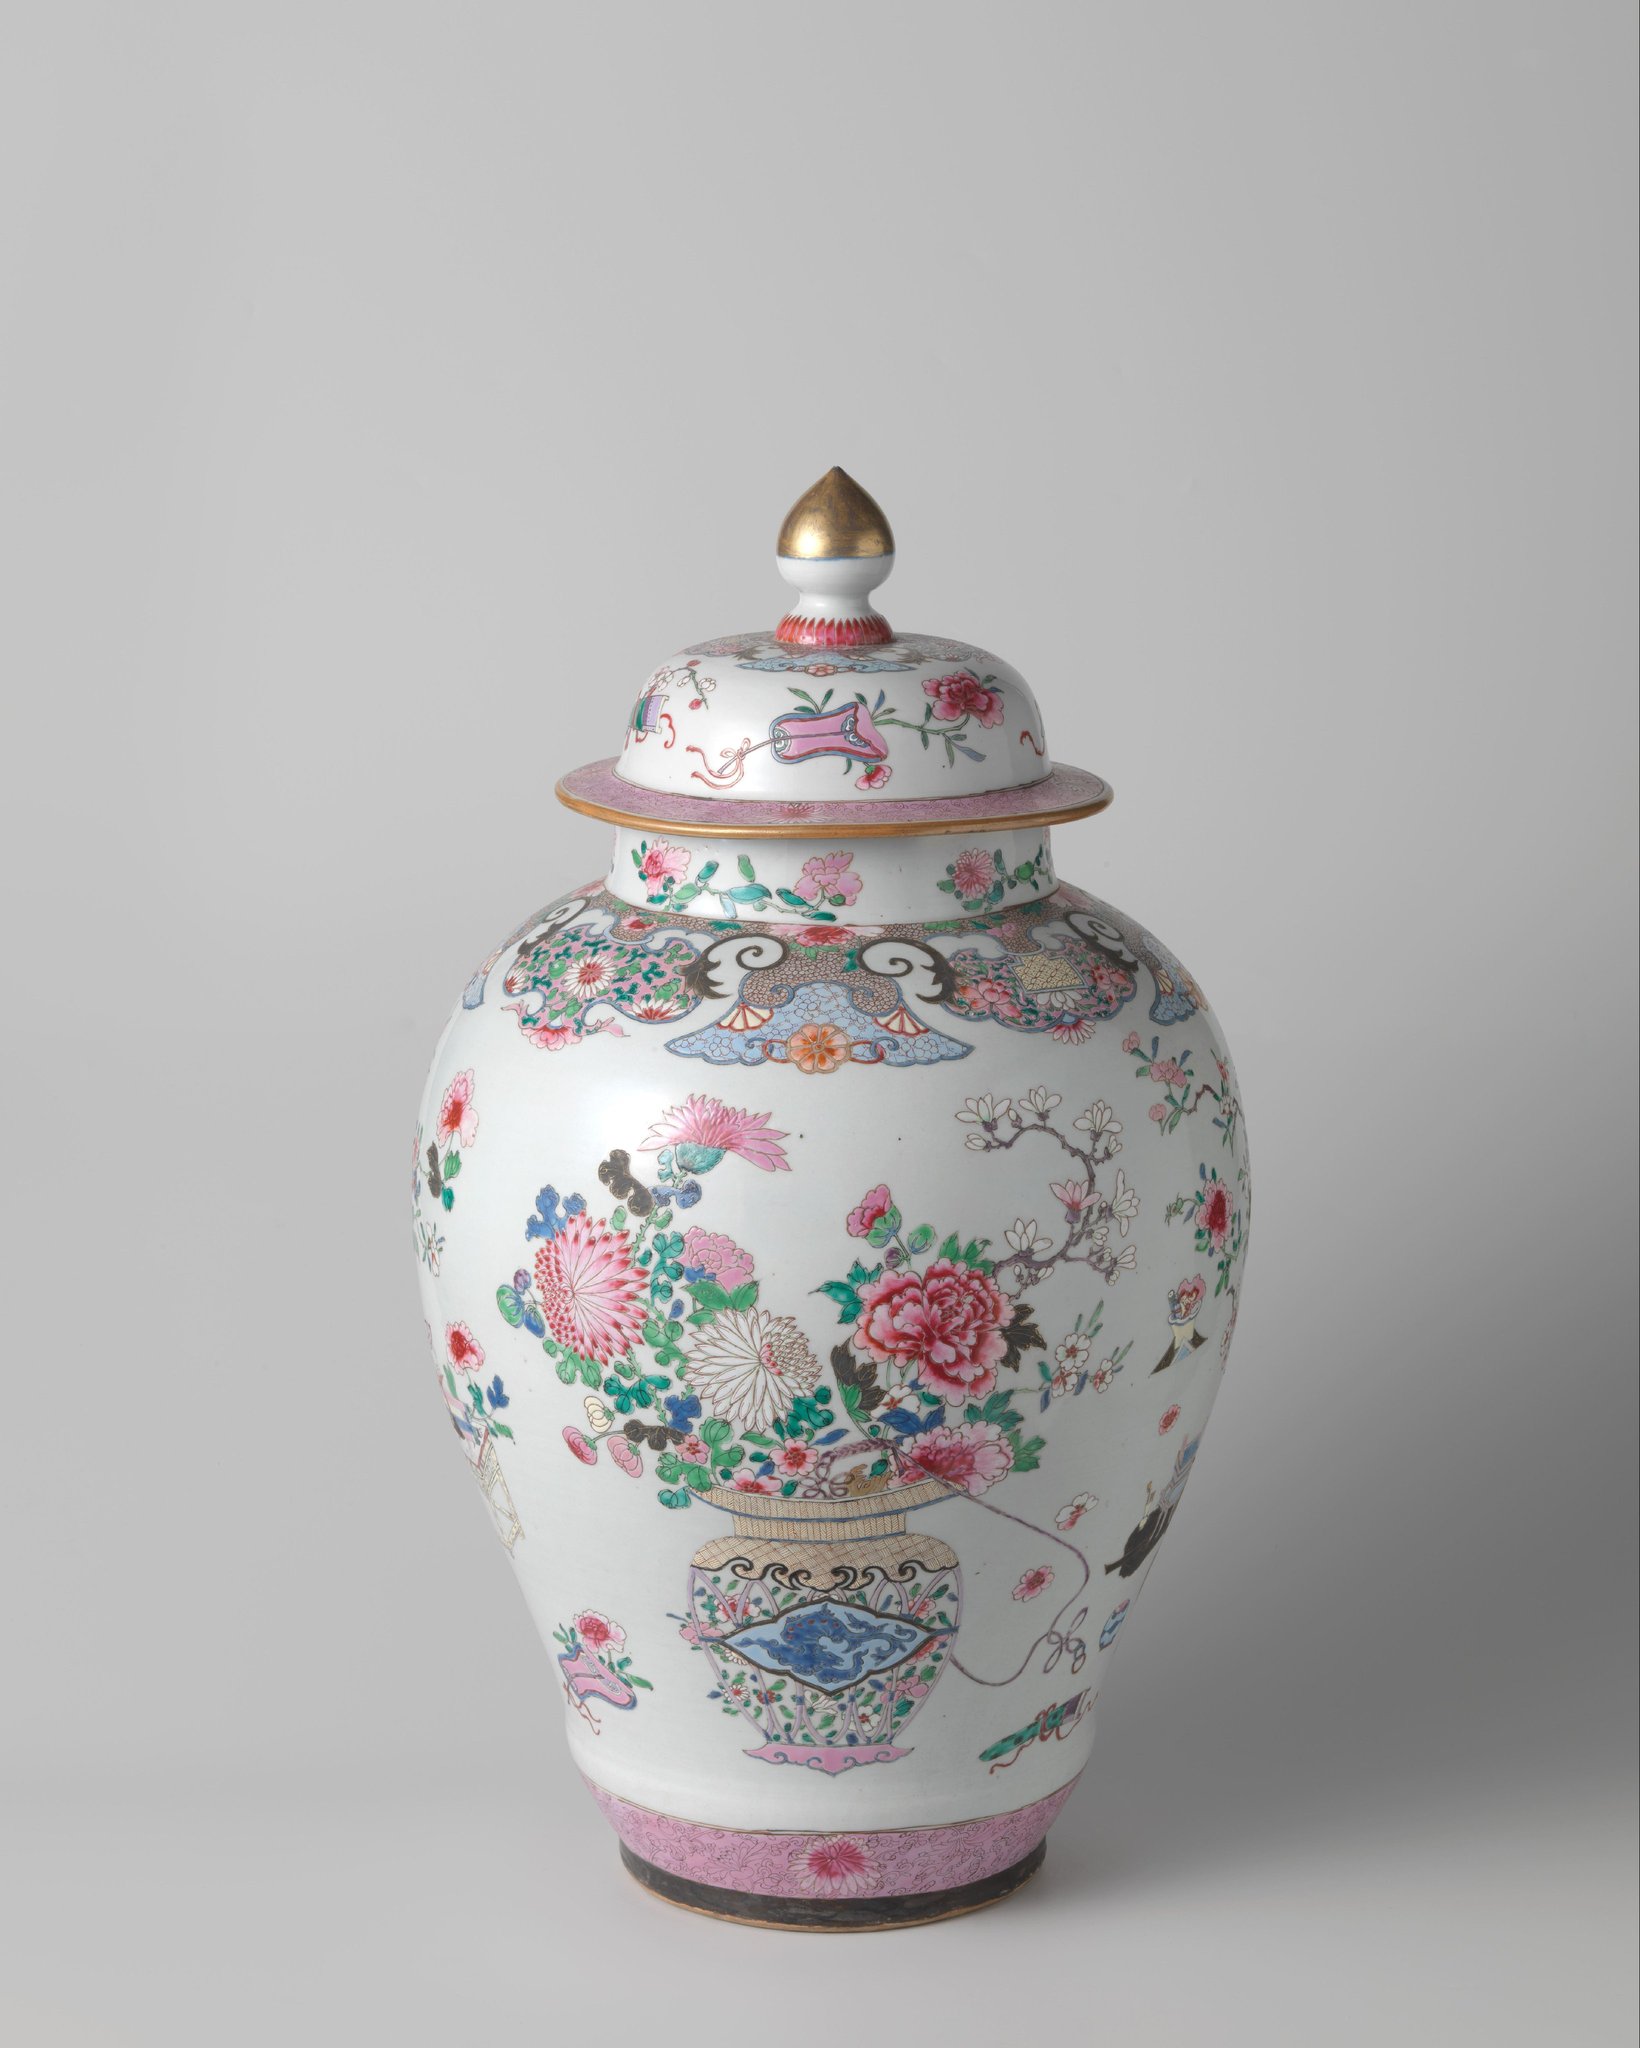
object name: covered jar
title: Ovoid covered jar with flower baskets and auspicious symbols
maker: Anonymous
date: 1850-1899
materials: cobalt, glaze, paint, porcelain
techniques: firing, gilding, turning, vitrification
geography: china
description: Eivormige dekselpot van porselein, beschilderd in onderglazuur blauw en op het glazuur in blauw, rood, roze, groen, zwart en goud. Op de wand tweemaal een opengewerkte hengselmand met een chilong (hoornloze draak) in een geschulpt cartouche. De mand is gevuld met bloem- en fruittakken (pioen, chrysant, prunus, vingercitroen, magnolia). Hiertussen ook tweemaal een bloemenvaas op een lage tafel. Op de vaas de kop van een shishi (leeuwhond) met een ring in zijn bek. De vaas is omgeven door geluksvoorwerpen (tafel met rollen, ruyi-scepter, waaier, qin, wierookbrander, kom met paddestoelen (lingzhi) en rollen). Op de schouder een onregelmatige band met pioenranken op 'kikkerdril', bladranken, chrysantranken, bloemrozetten en perzikbloesem 'crackled ice'. Rond de voet een band met chrysantranken. De hals met pioentakken. Dekselpot is onderdeel van kaststel AK-RBK-15919. Famille rose.